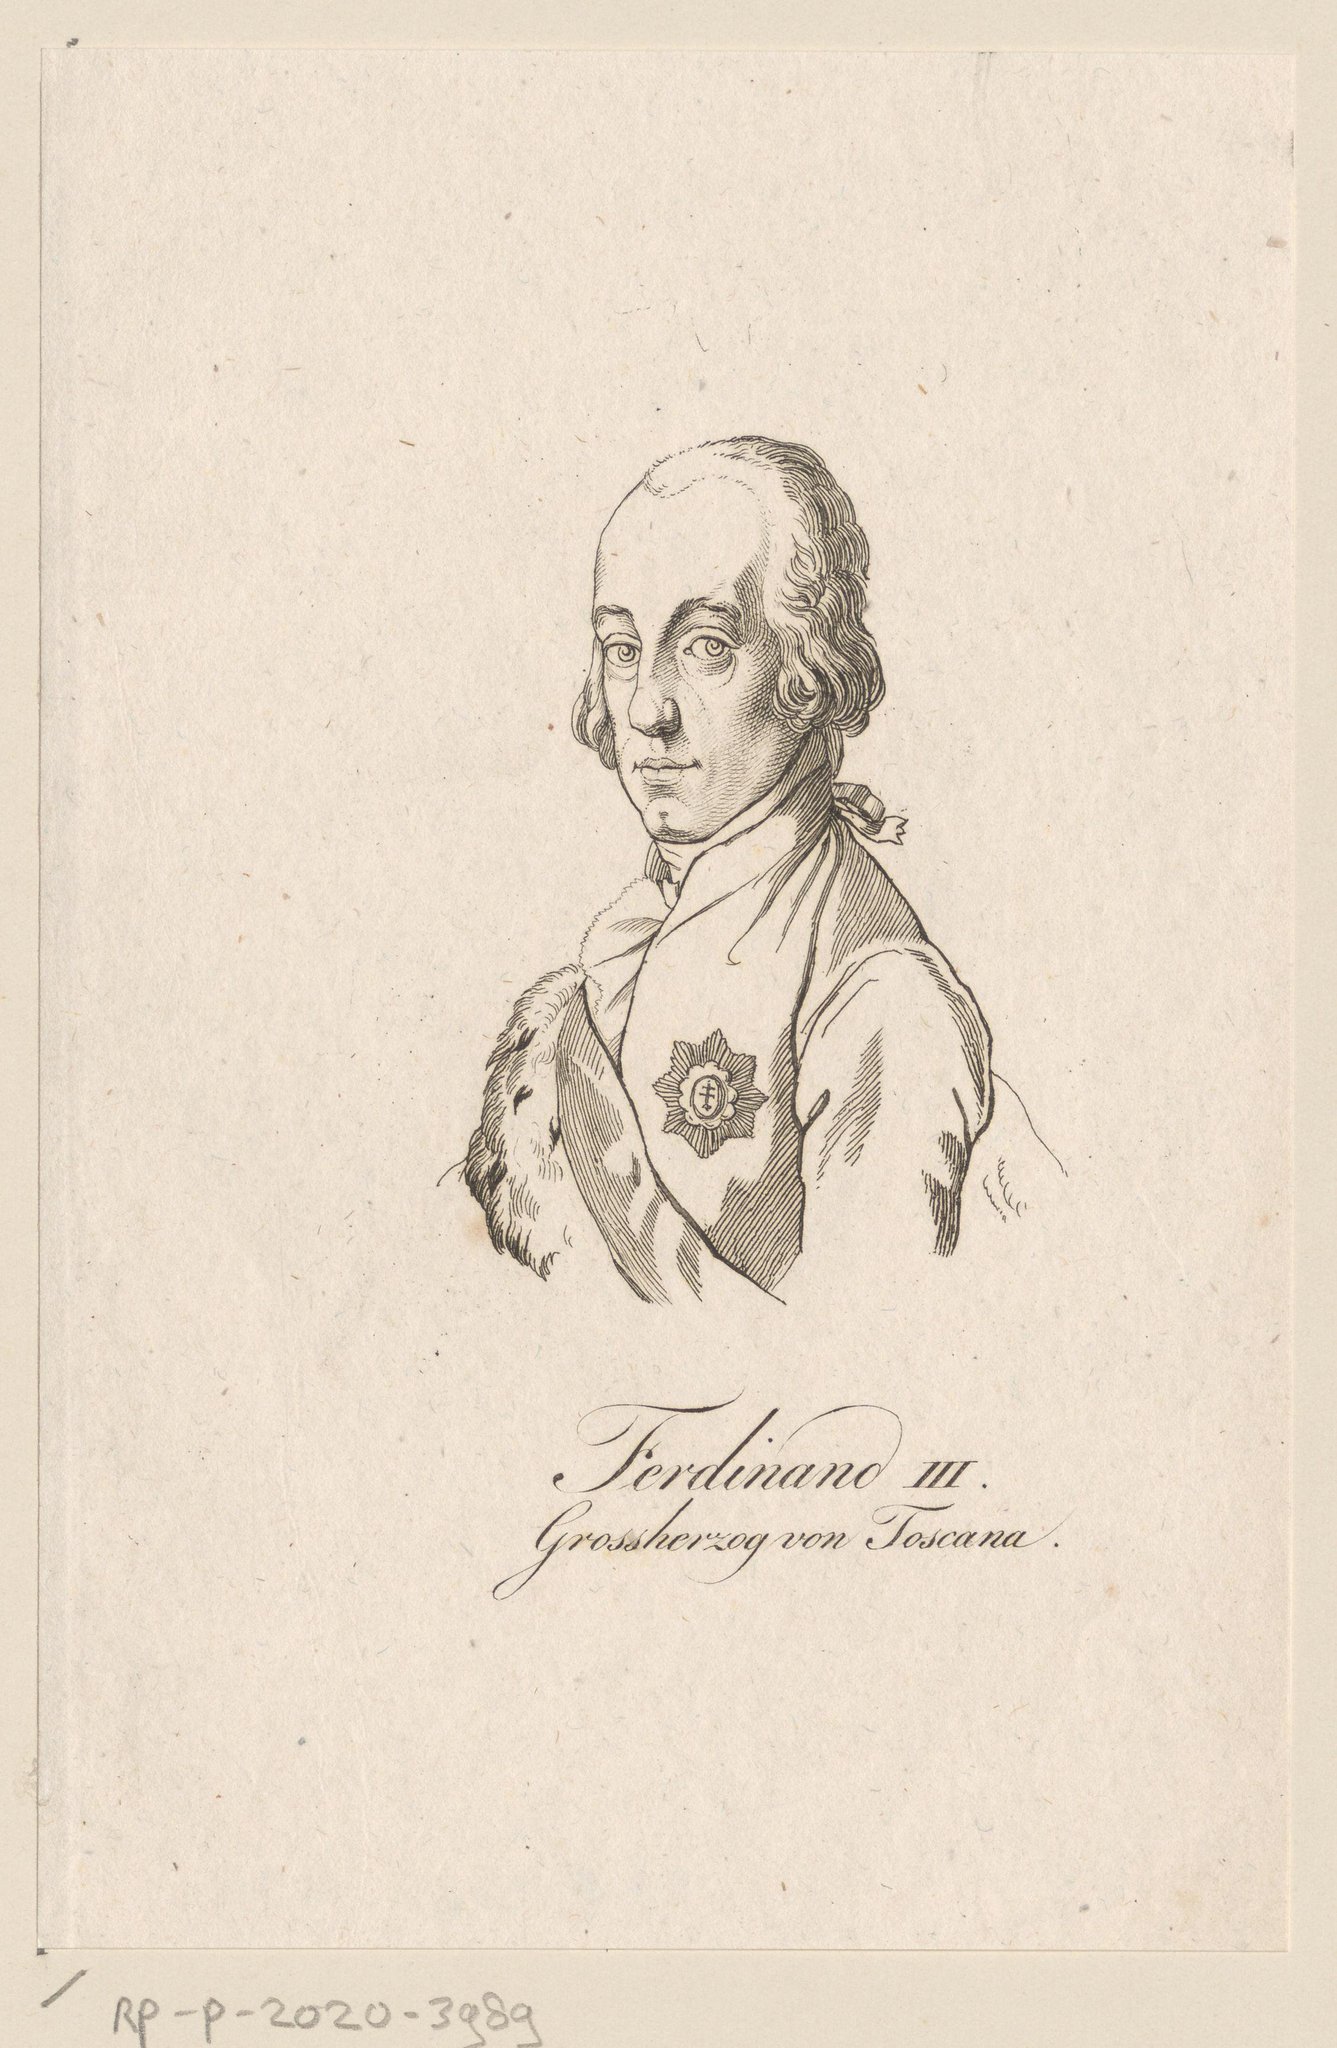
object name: print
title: Portret van Ferdinand III van Toscane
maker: Anonymous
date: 1814-1850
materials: paper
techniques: etching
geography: germany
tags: ferdinand iii (groothertog van toscane), historical persons